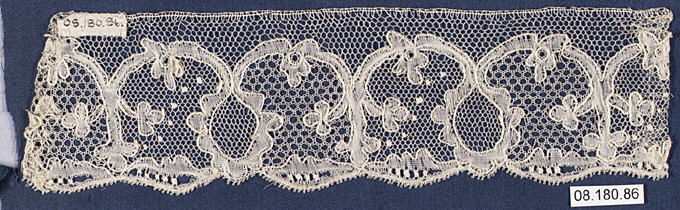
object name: fragment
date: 1801-1900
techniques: lace